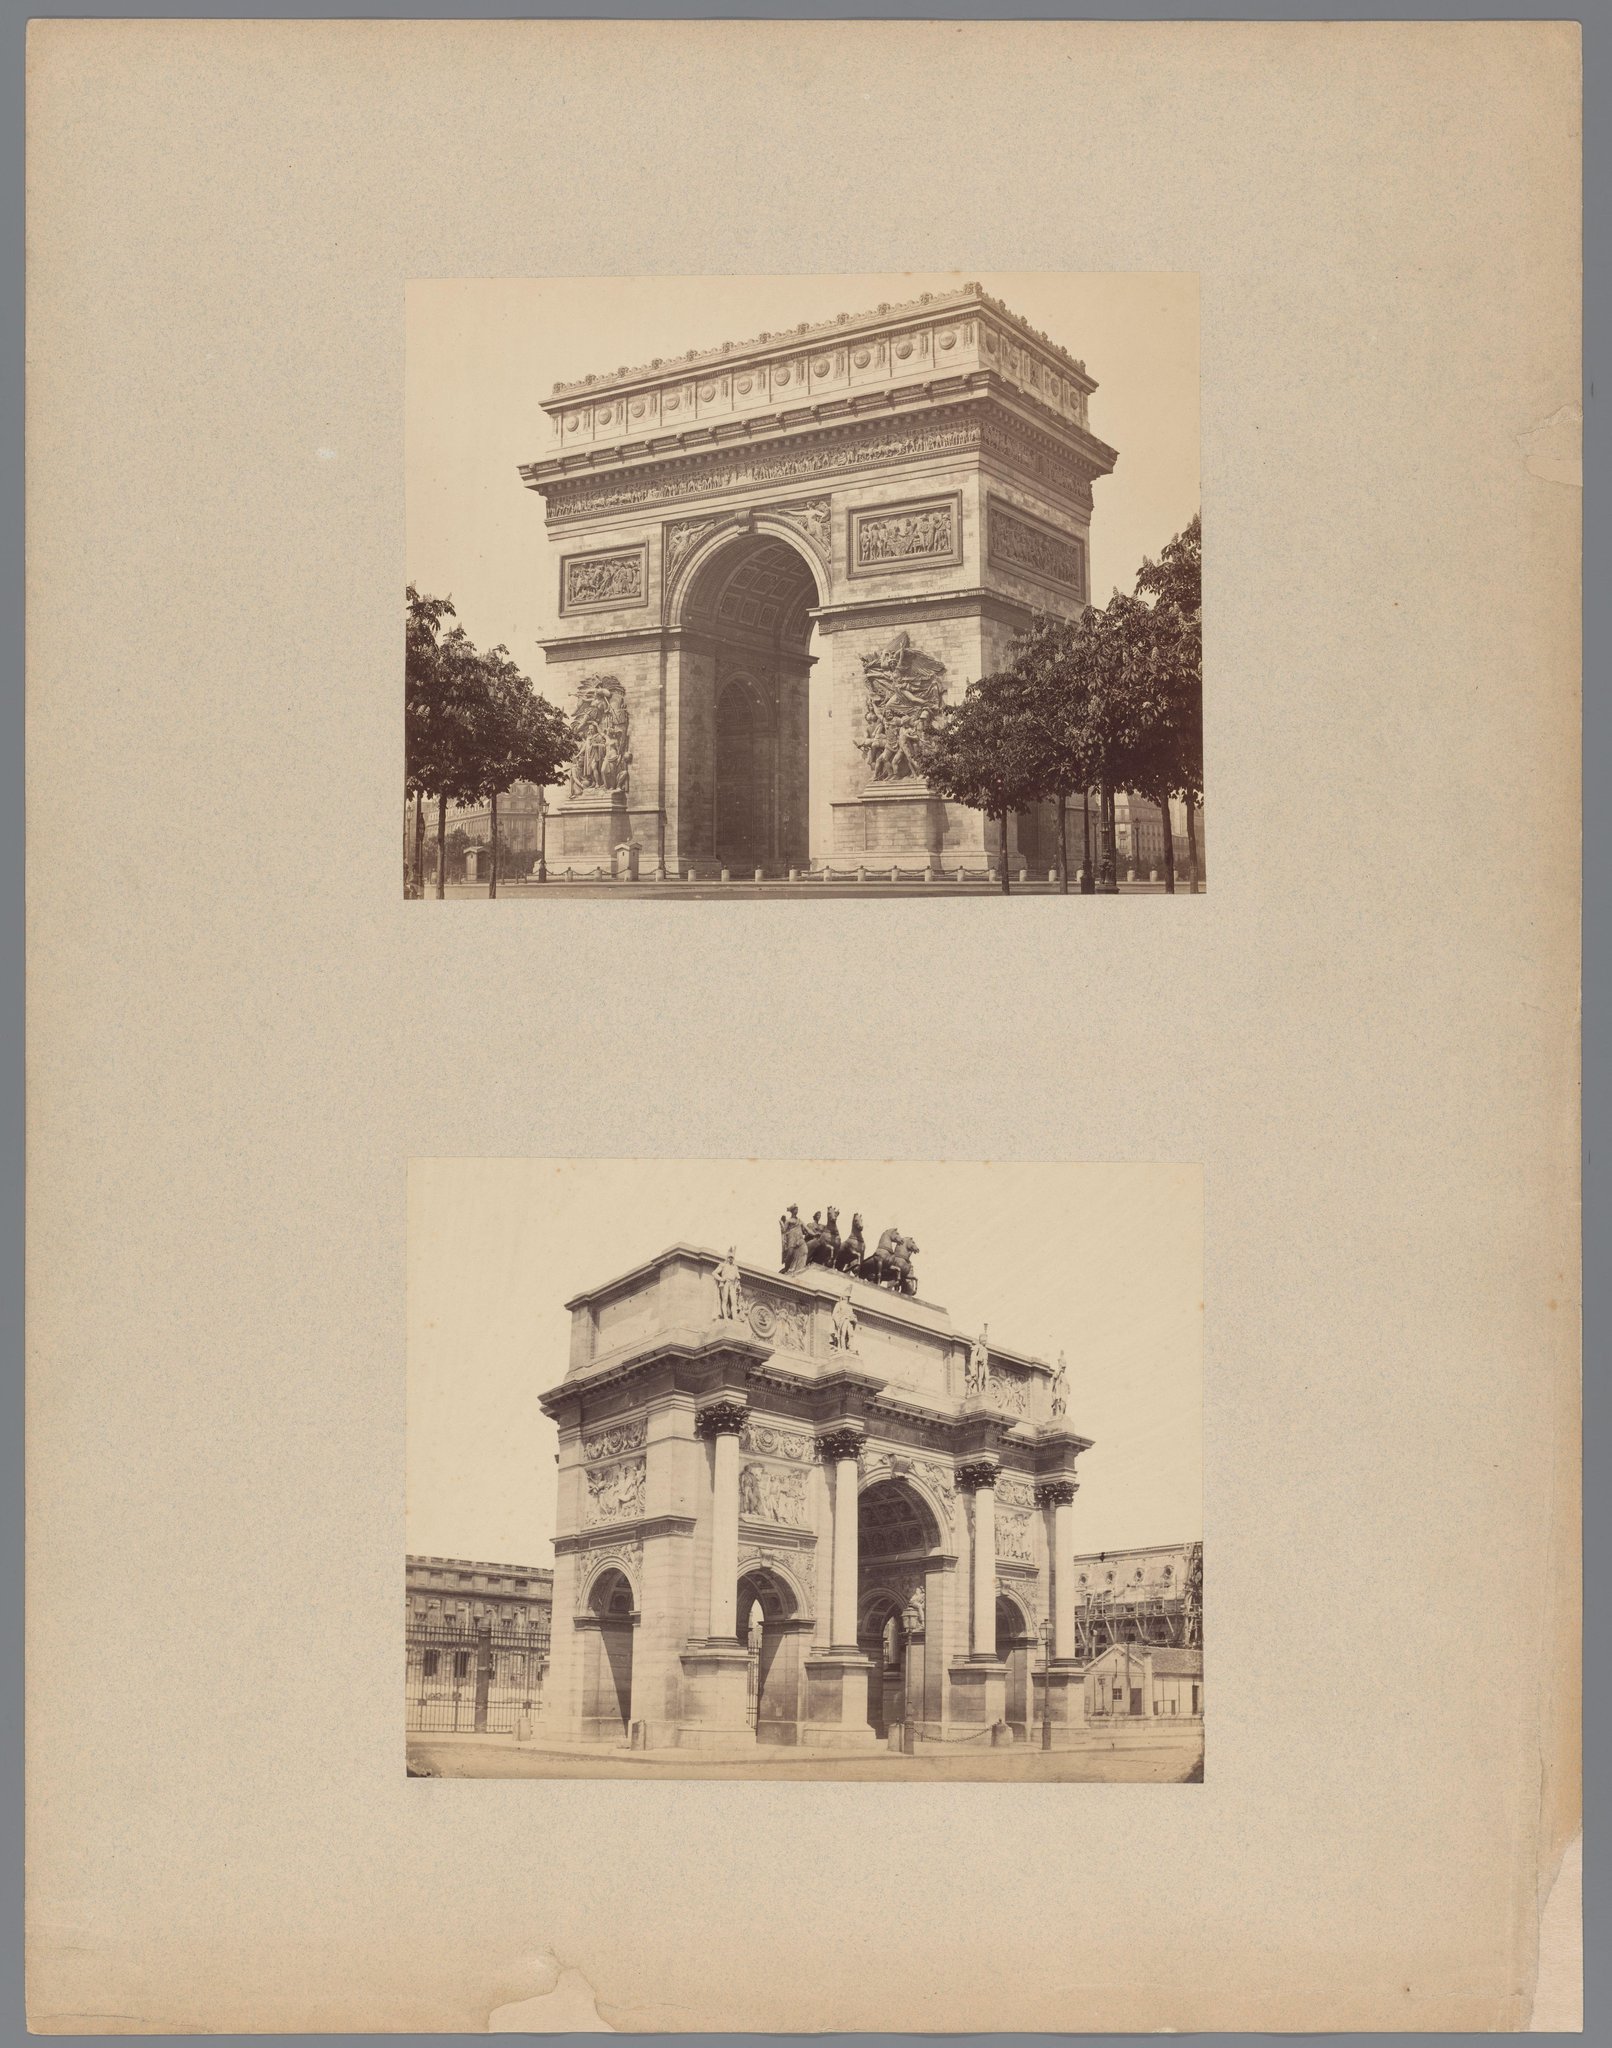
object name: photograph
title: Blad met twee foto's van de Arc de Triomphe te Parijs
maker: Anonymous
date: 1850-1900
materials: cardboard, photographic support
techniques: albumen print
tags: arc de triomphe